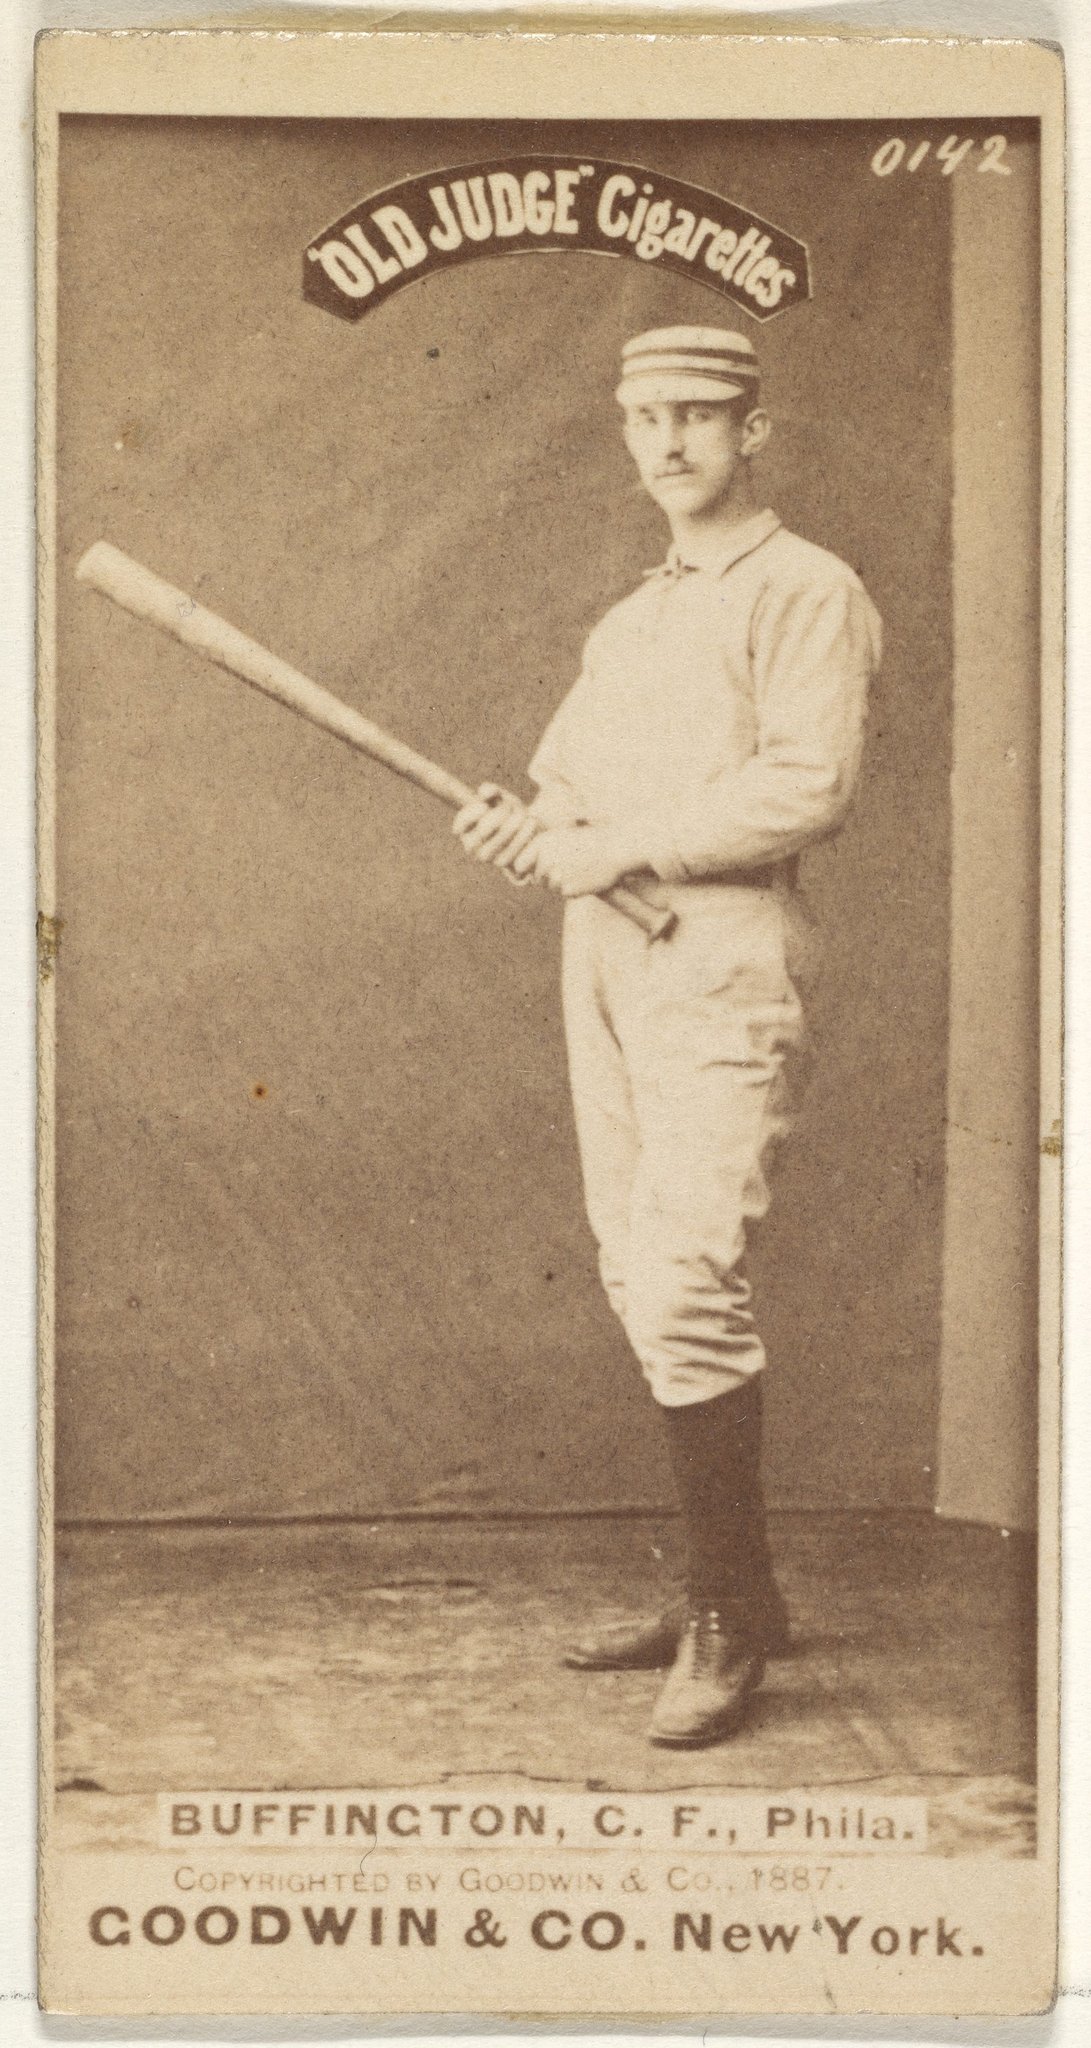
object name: baseball card, photograph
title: Charles G. Buffington, Center Field, Philadelphia, from the Old Judge series (N172) for Old Judge Cigarettes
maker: goodwin & company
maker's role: publisher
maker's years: 1850-1950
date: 1887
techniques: albumen silver print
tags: men,portraits,baseball,athletes